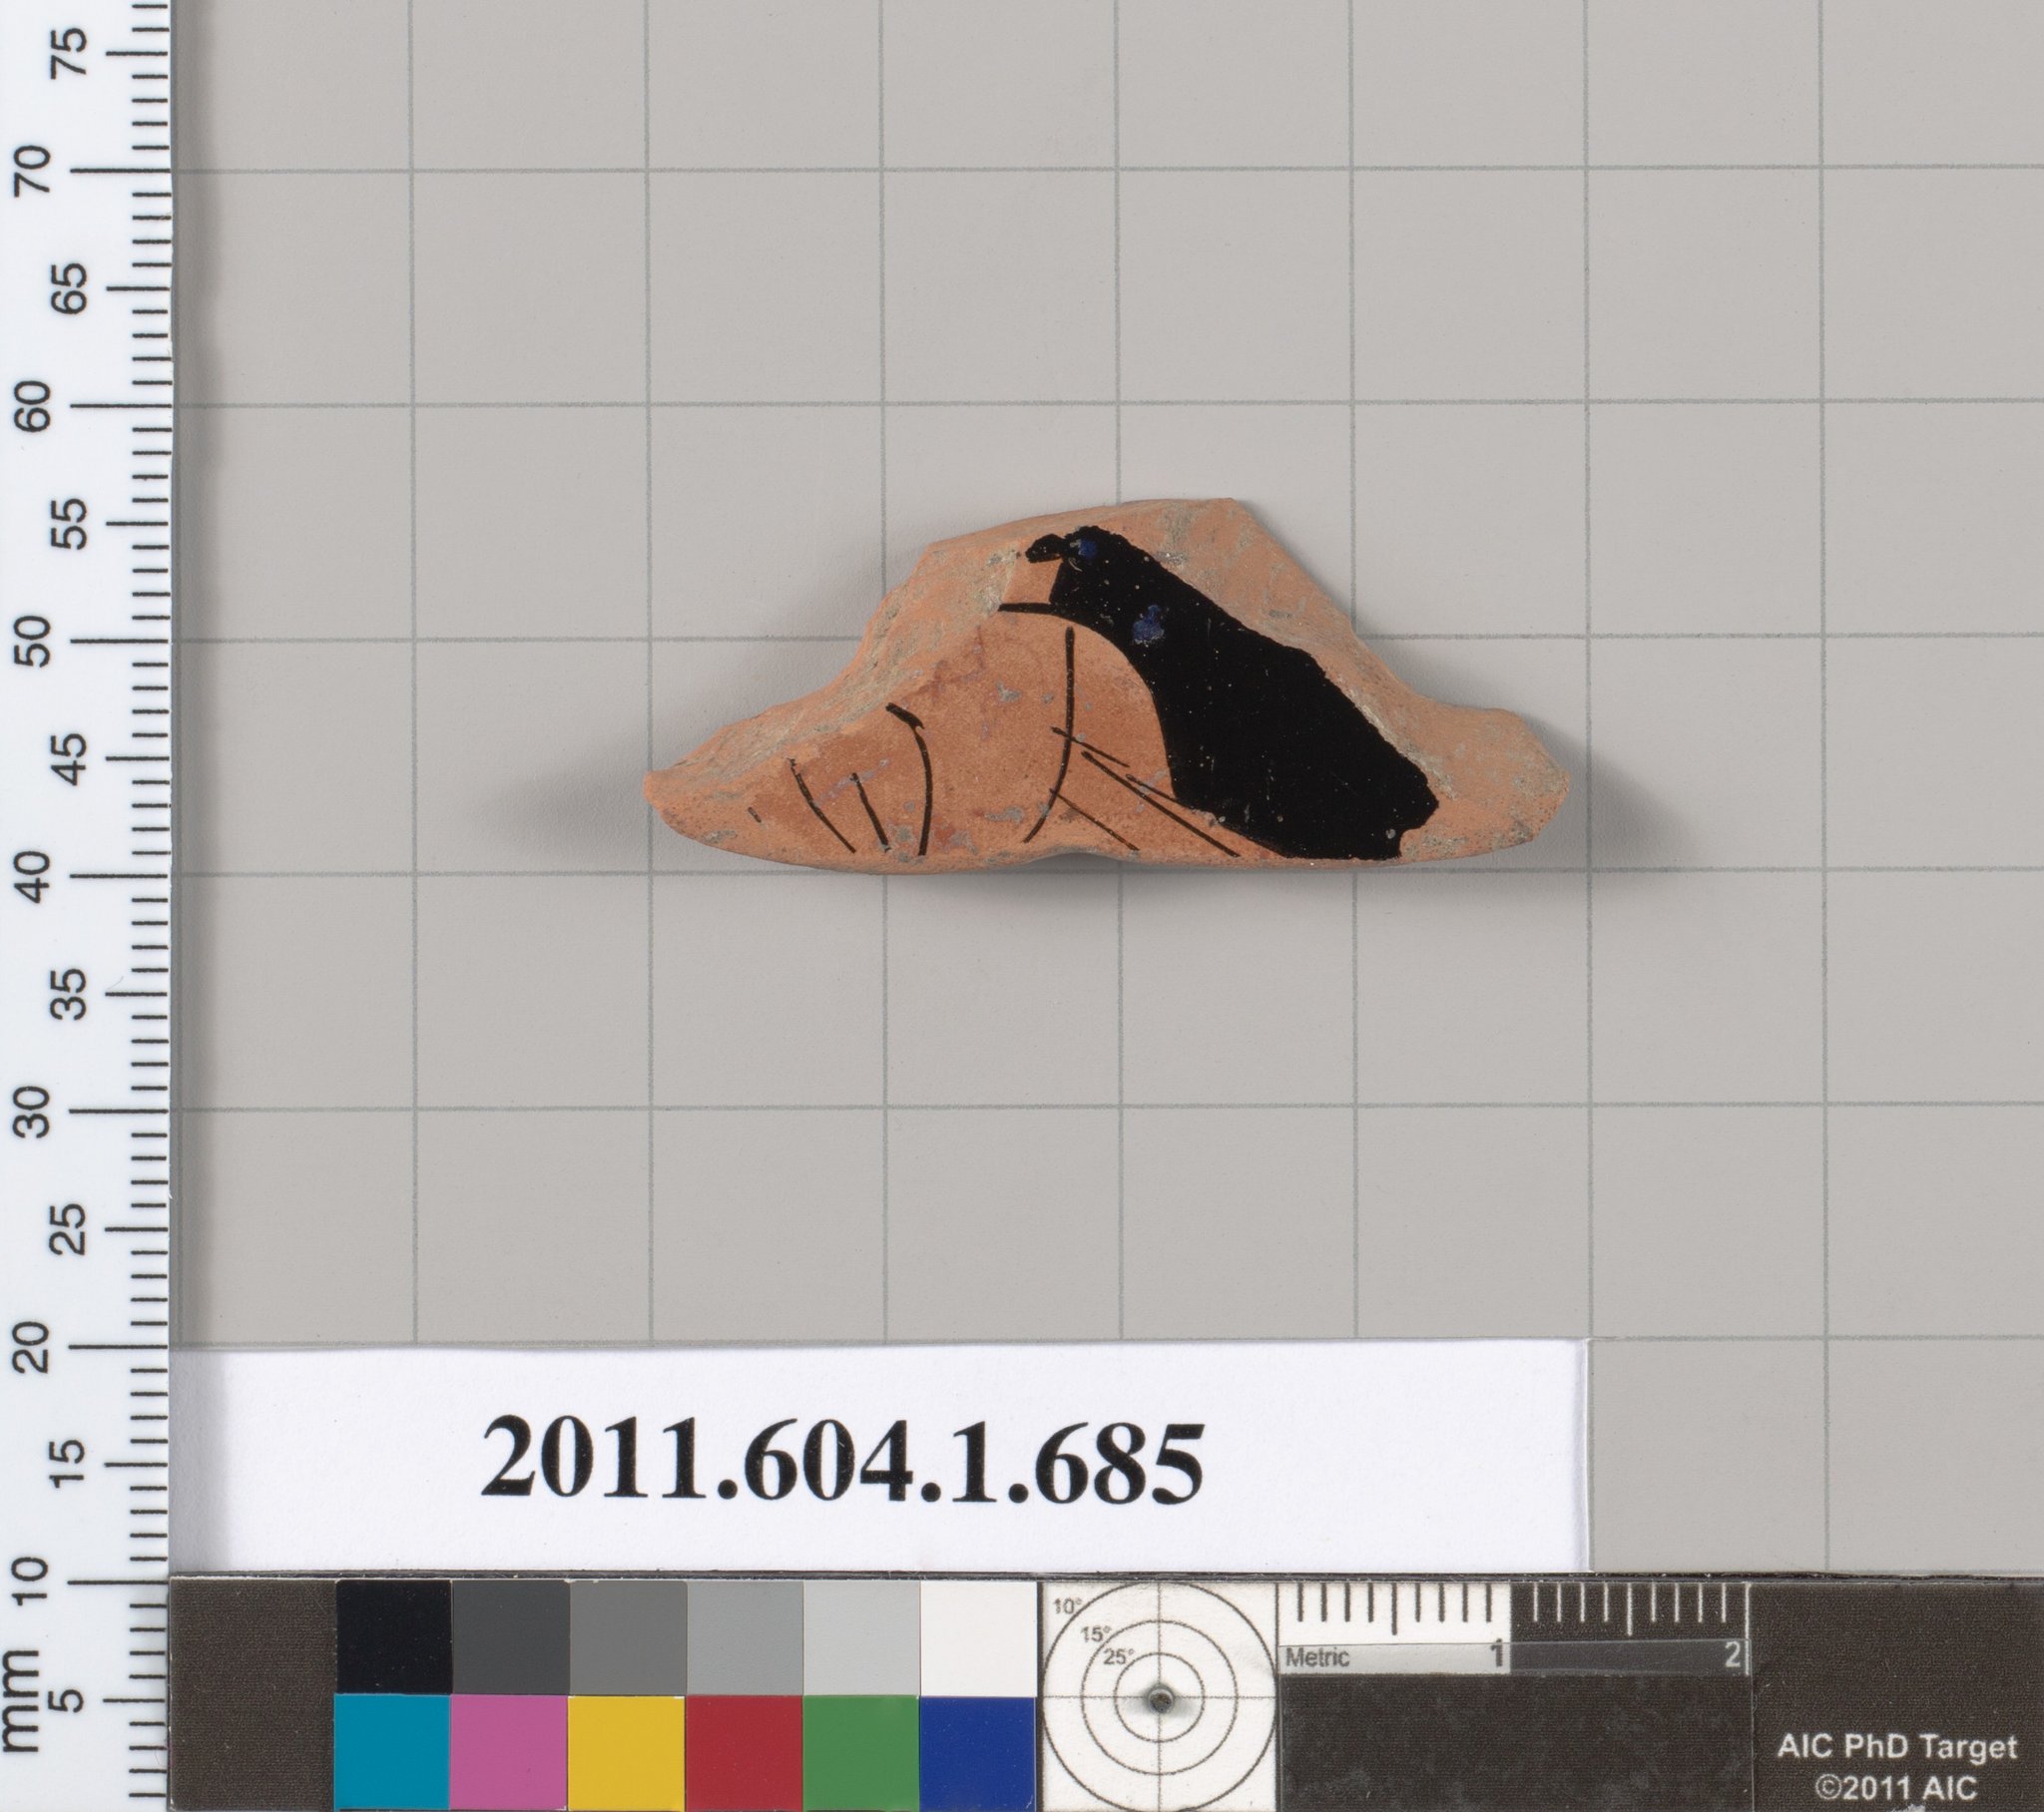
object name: kylix fragment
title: Terracotta fragment of a kylix (drinking cup)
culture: greek, attic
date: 500-401 BCE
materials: terracotta